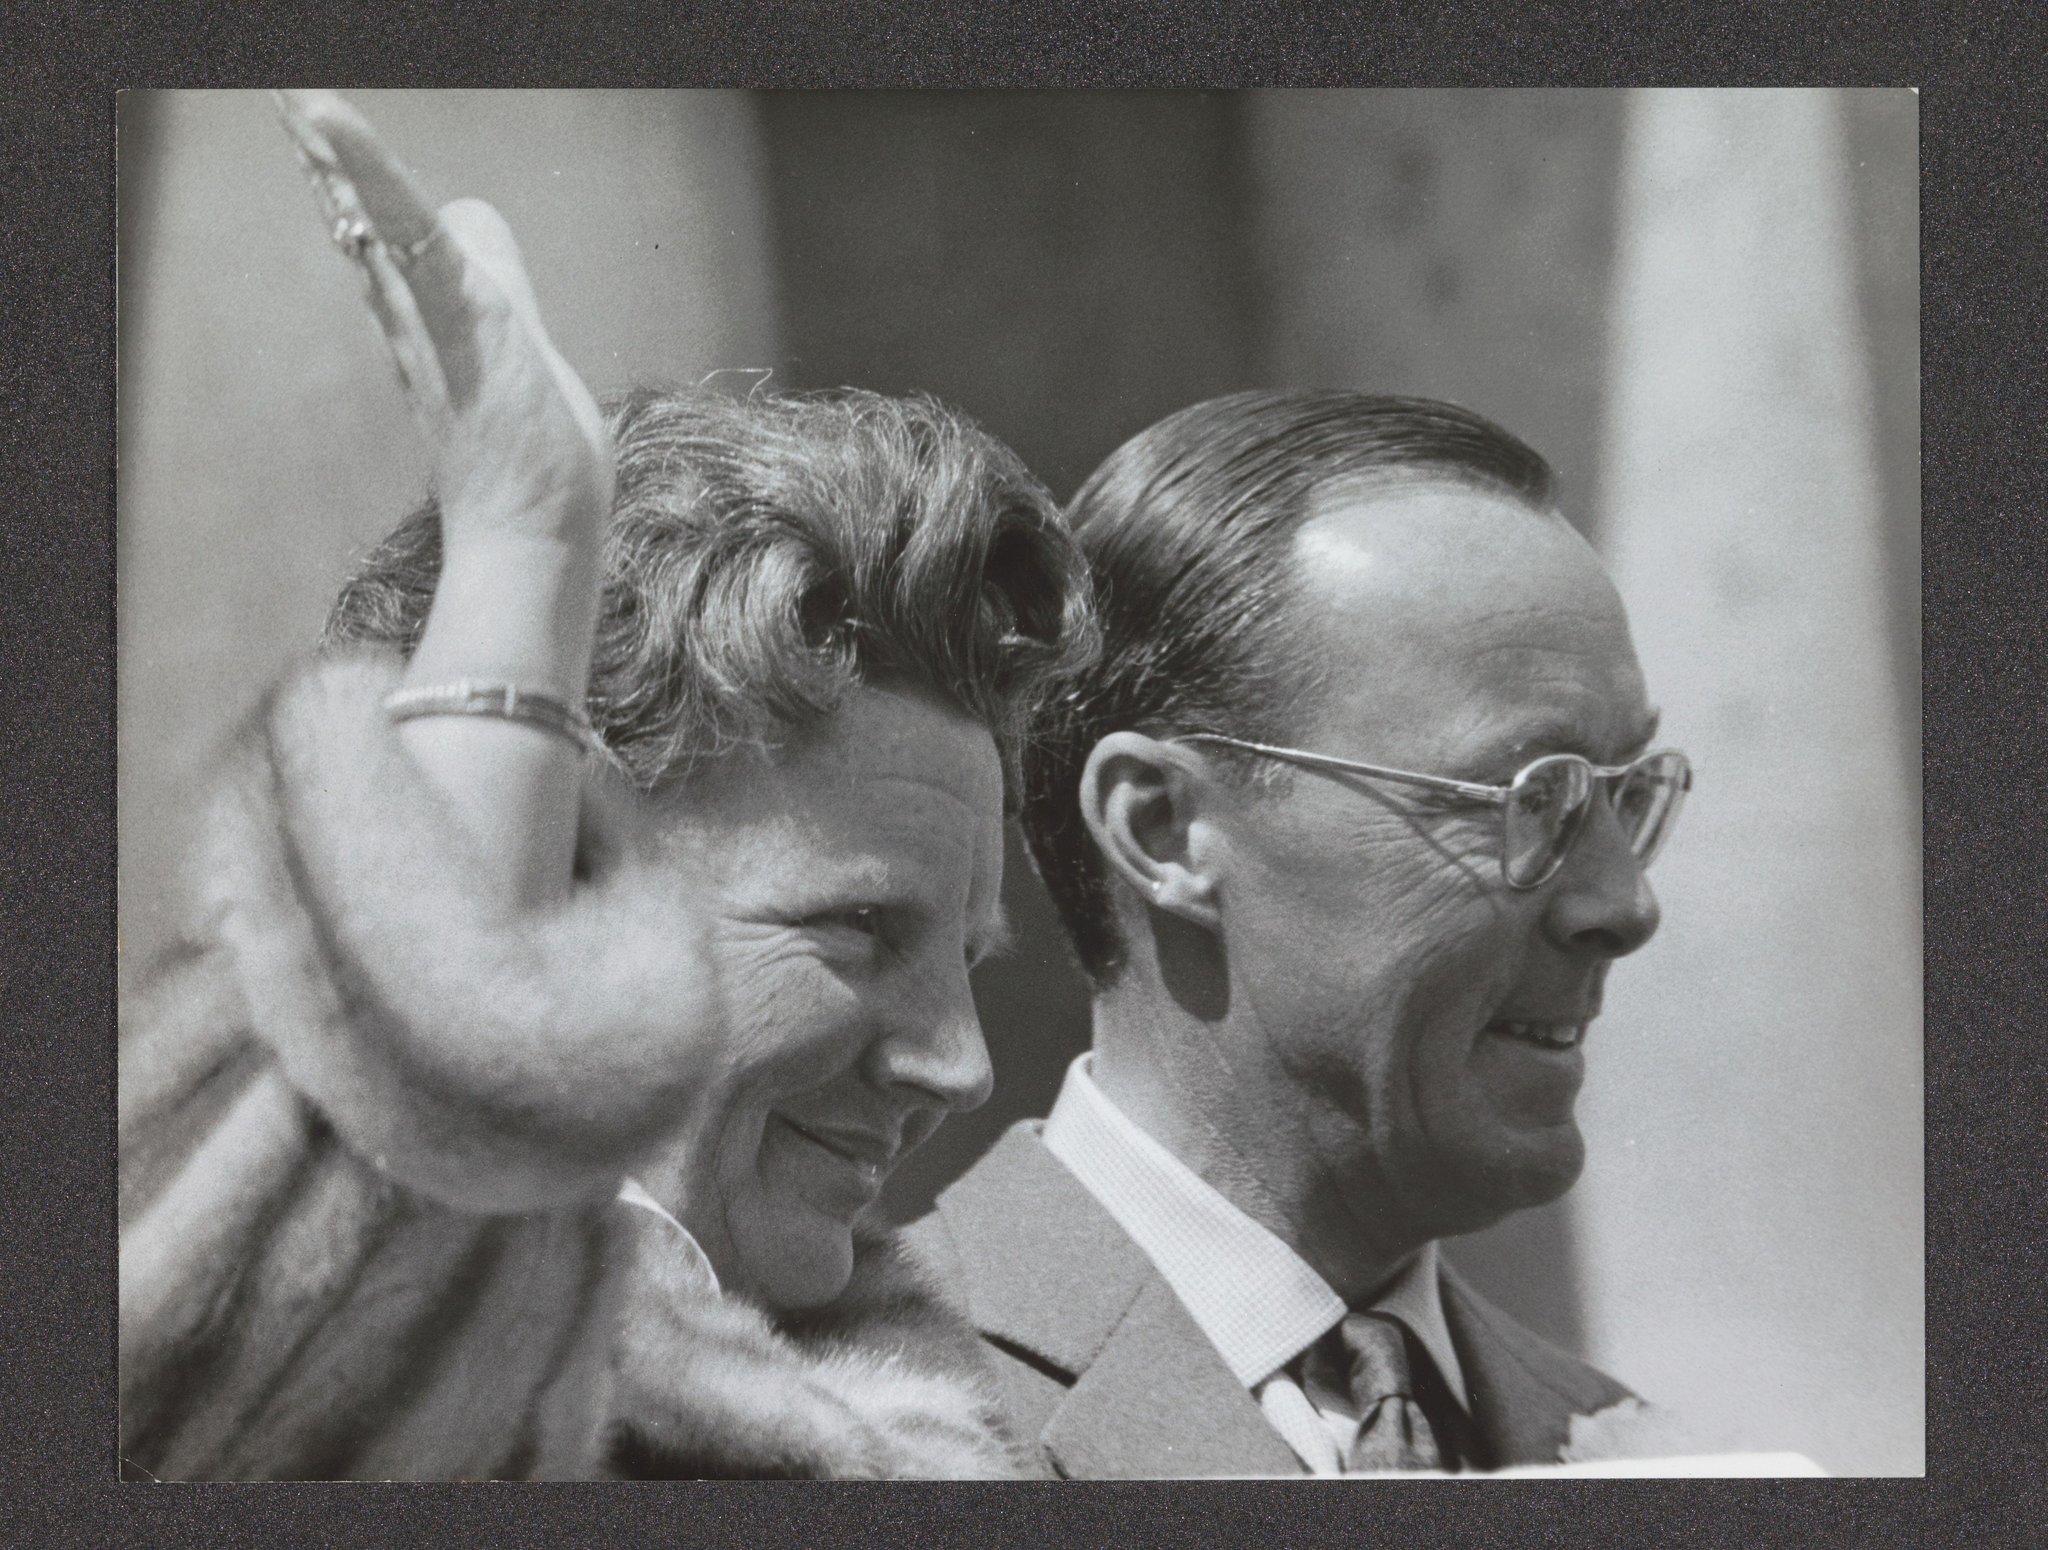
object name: photograph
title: Queen Juliana and Prince Bernhard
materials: paper, photographic support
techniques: gelatin silver print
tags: utrecht, bernhard (prins der nederlanden), the hague, juliana of the netherlands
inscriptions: caption: ‘Birthday feast of dutch Queen Julian at Royal Palace at Soestdijk. Photo: Queen Juliana and Prince Bernhard Foto-Anefo (Harry Pot) 30-460’